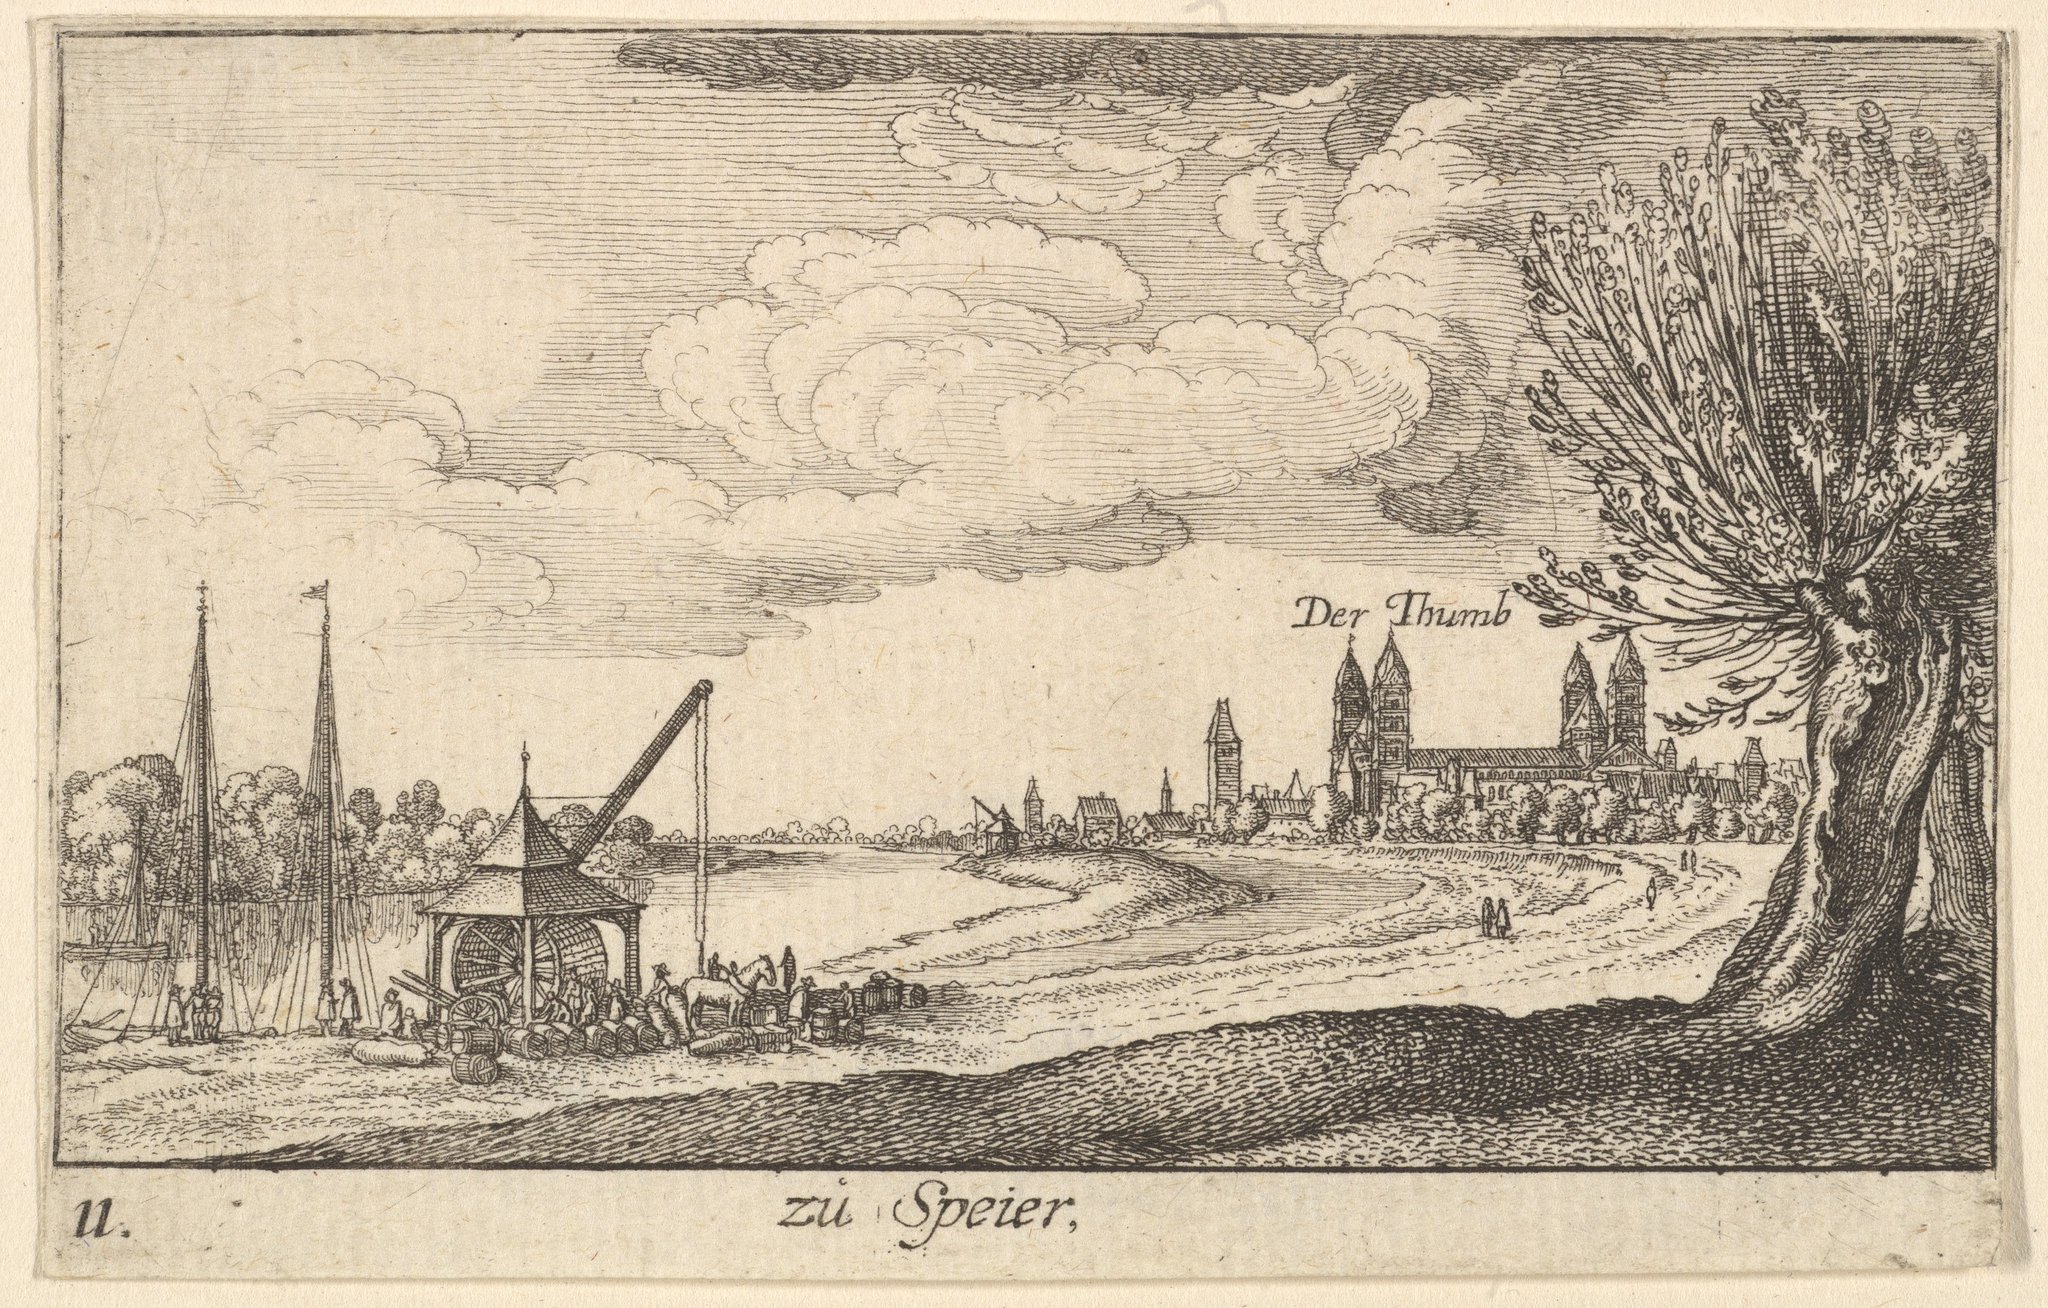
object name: print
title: Speyer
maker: wenceslaus hollar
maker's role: artist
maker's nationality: bohemian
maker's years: 1607-1677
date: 1635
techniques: etching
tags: towns,rivers